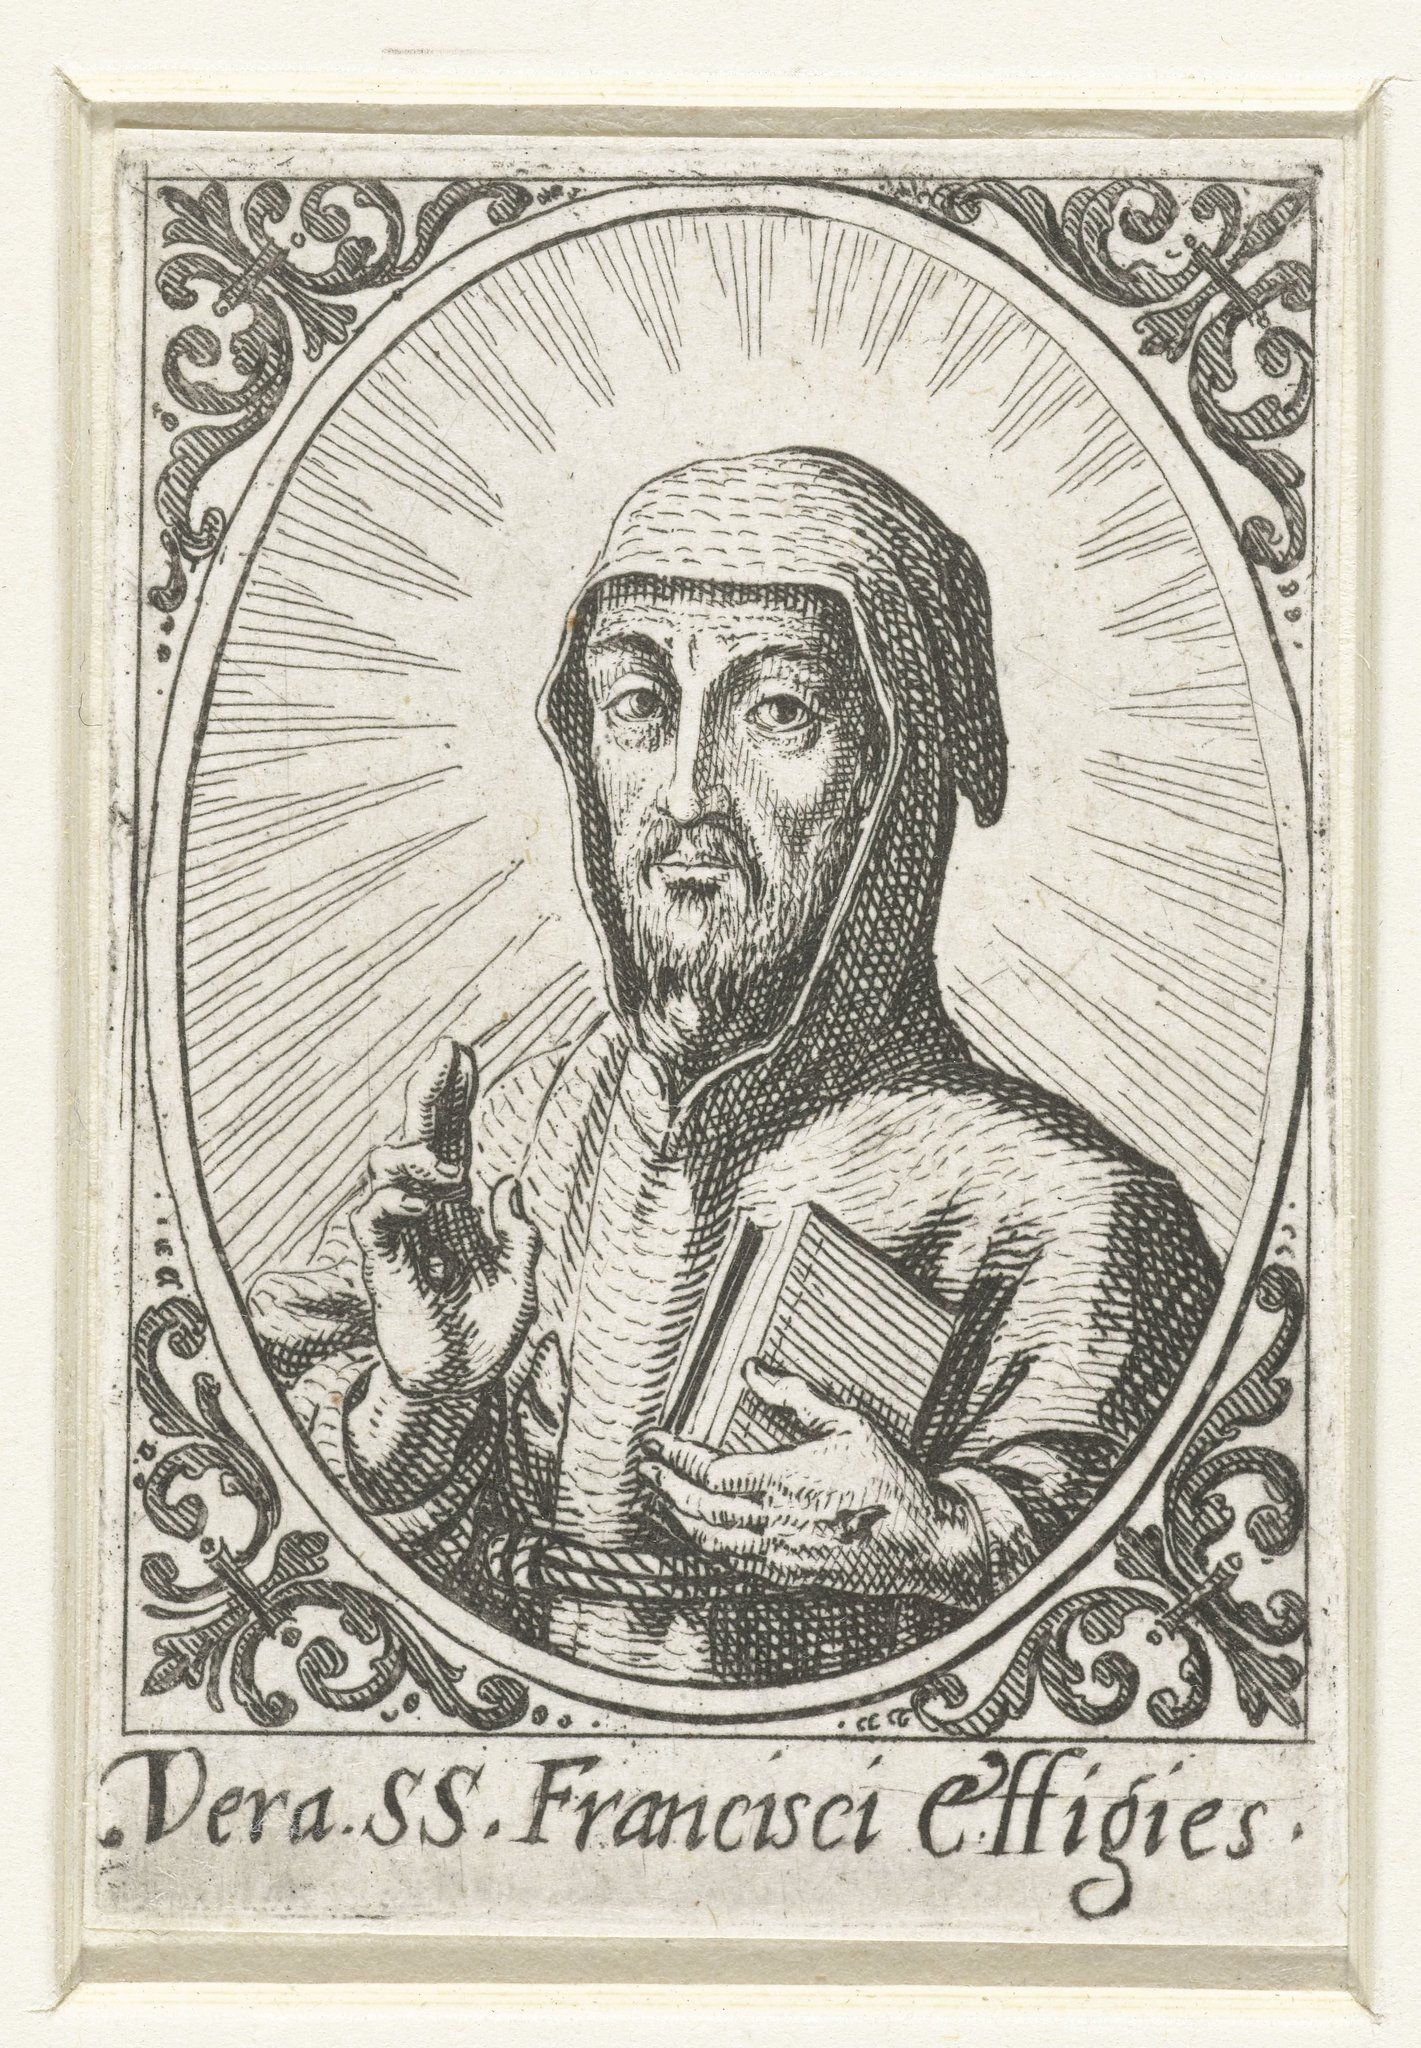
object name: print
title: Portret van de Heilige Franciscus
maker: jacques callot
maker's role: draughtsman, print maker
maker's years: 1592-1635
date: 1620-1621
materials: paper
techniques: engraving, etching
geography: florence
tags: founder of the order of friars minor (franciscans), francis(cus) of assisi; possible attributes: book, crucifix, lily, skull, stigmata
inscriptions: collector's mark: Lugt 240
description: Busteportret van de Heilige Franciscus, in de linkerhand een boek, de rechterhand opgestoken in een zegenend gebaar. Onder de voorstelling een onderschrift in Latijn.